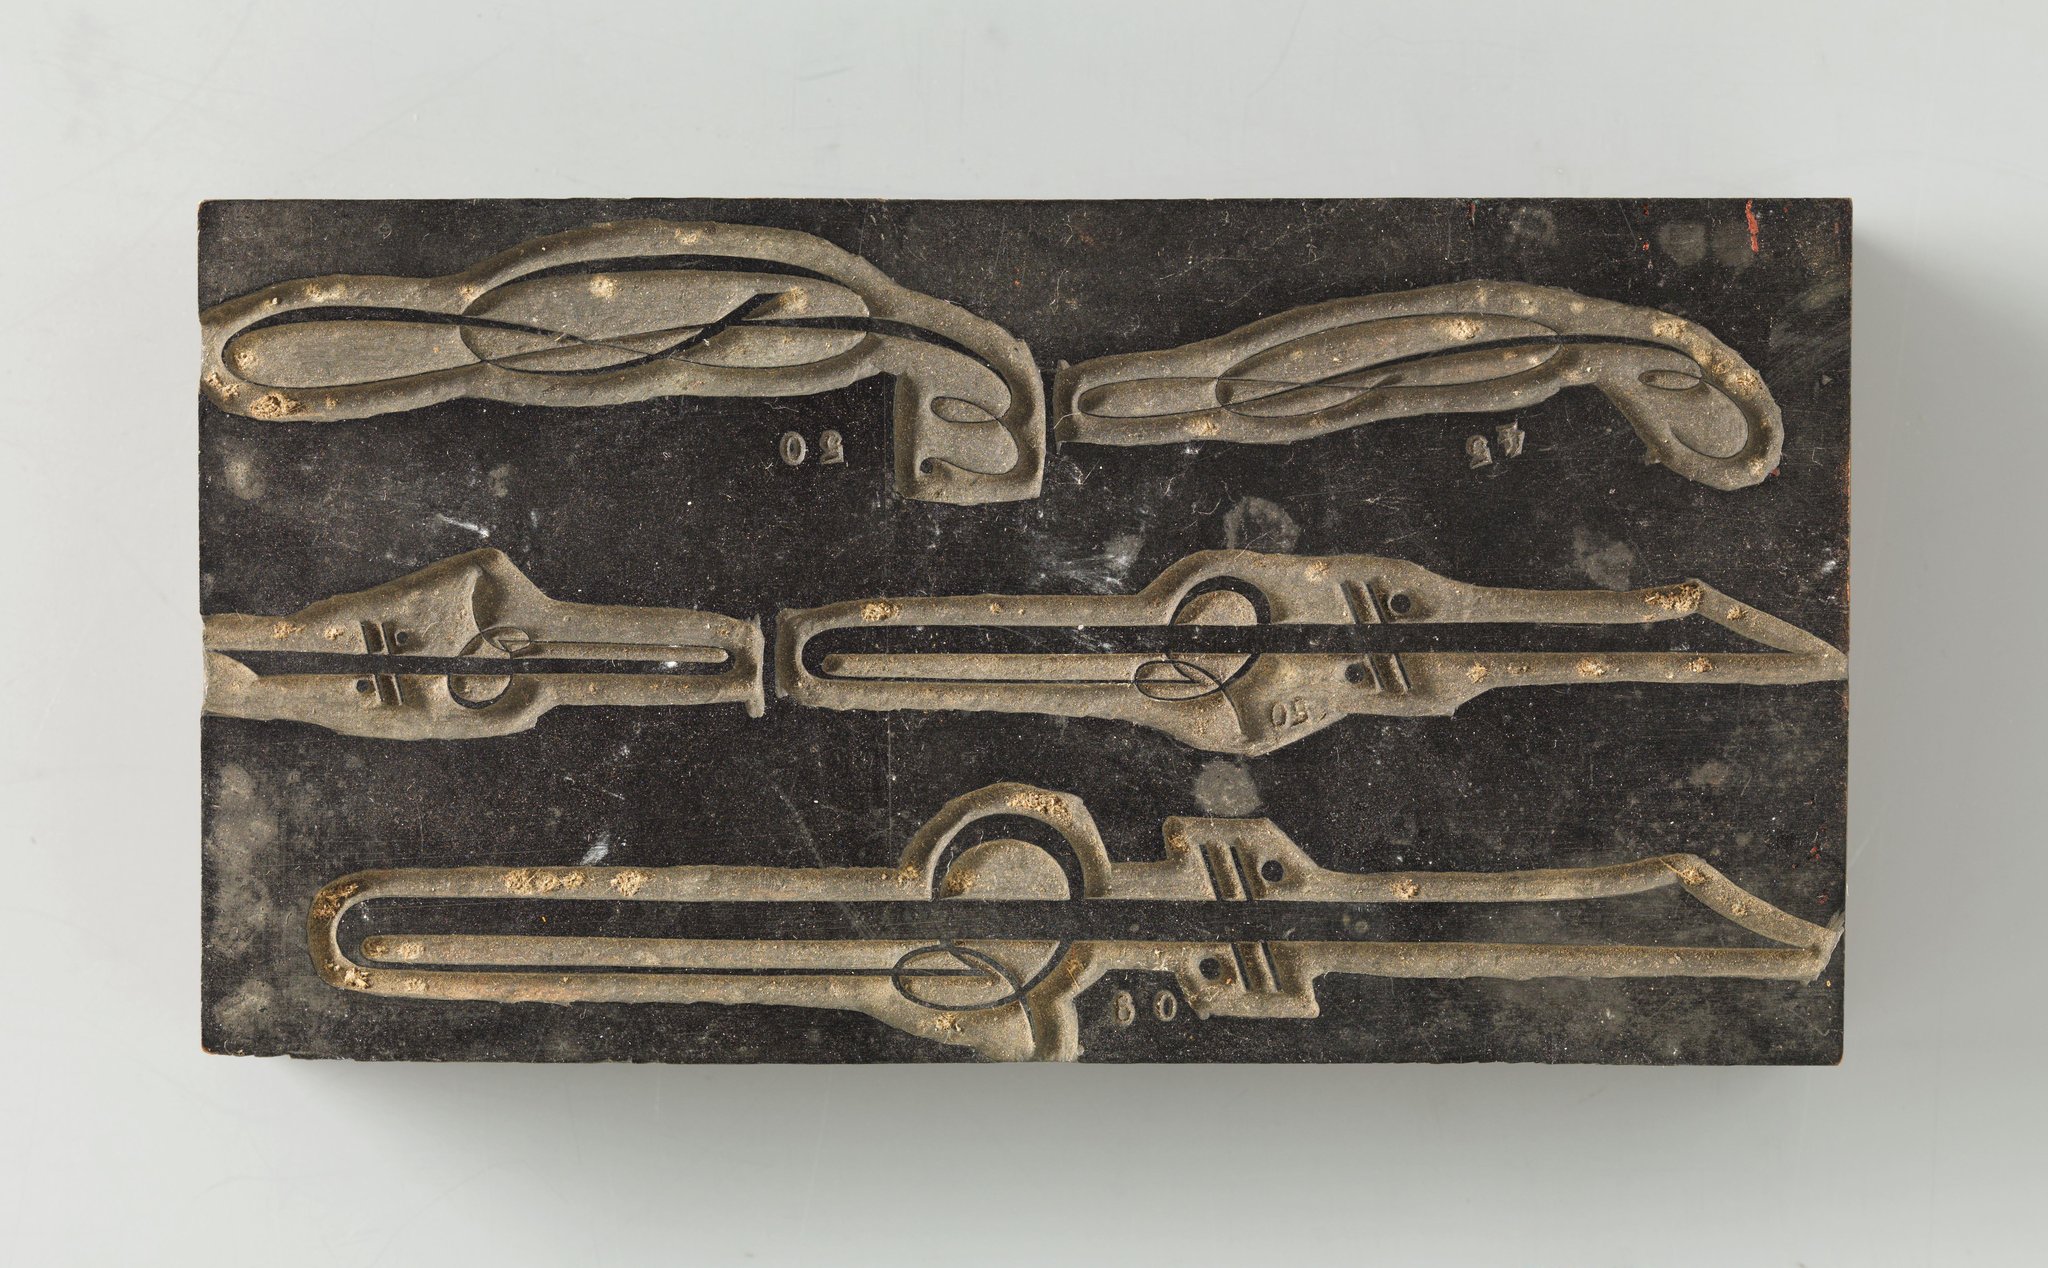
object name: houtblok kopshout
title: Muzieksleutels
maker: Anonymous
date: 1870-1920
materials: wood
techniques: engraving